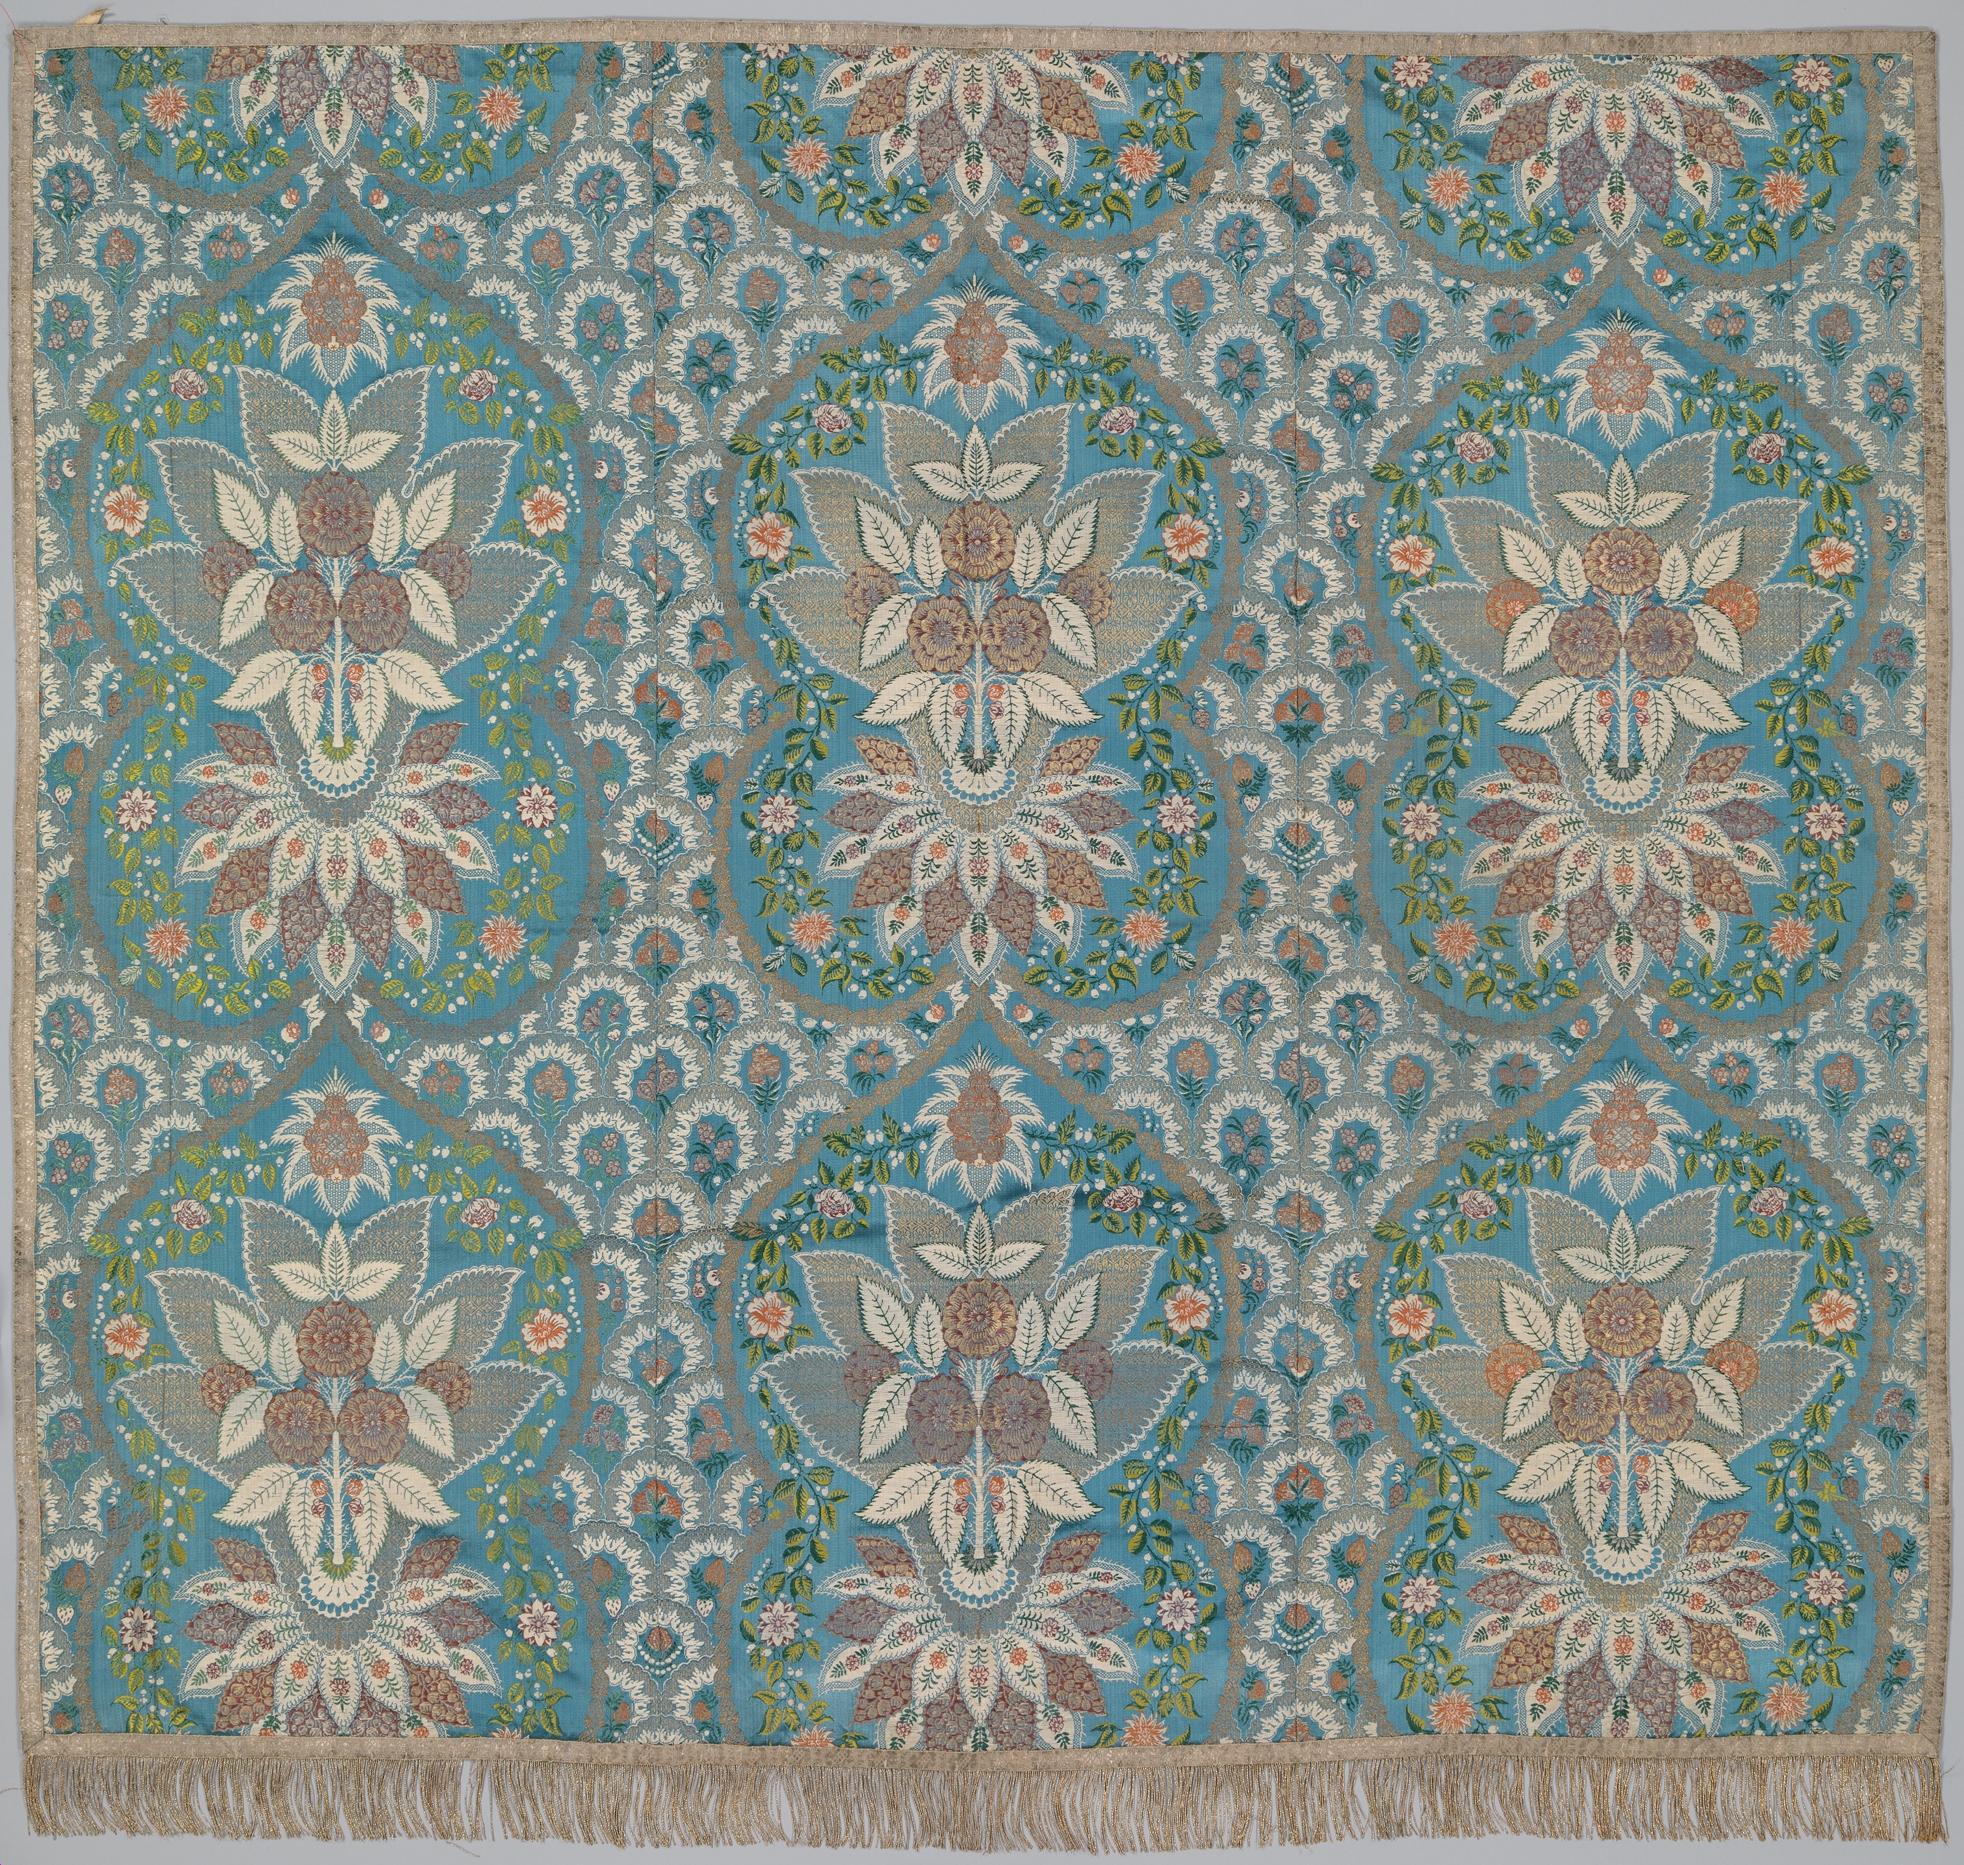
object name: panel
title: Panel of lace-patterned silk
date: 1720-1729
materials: metal thread, silk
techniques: lampas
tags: flowers,leaves